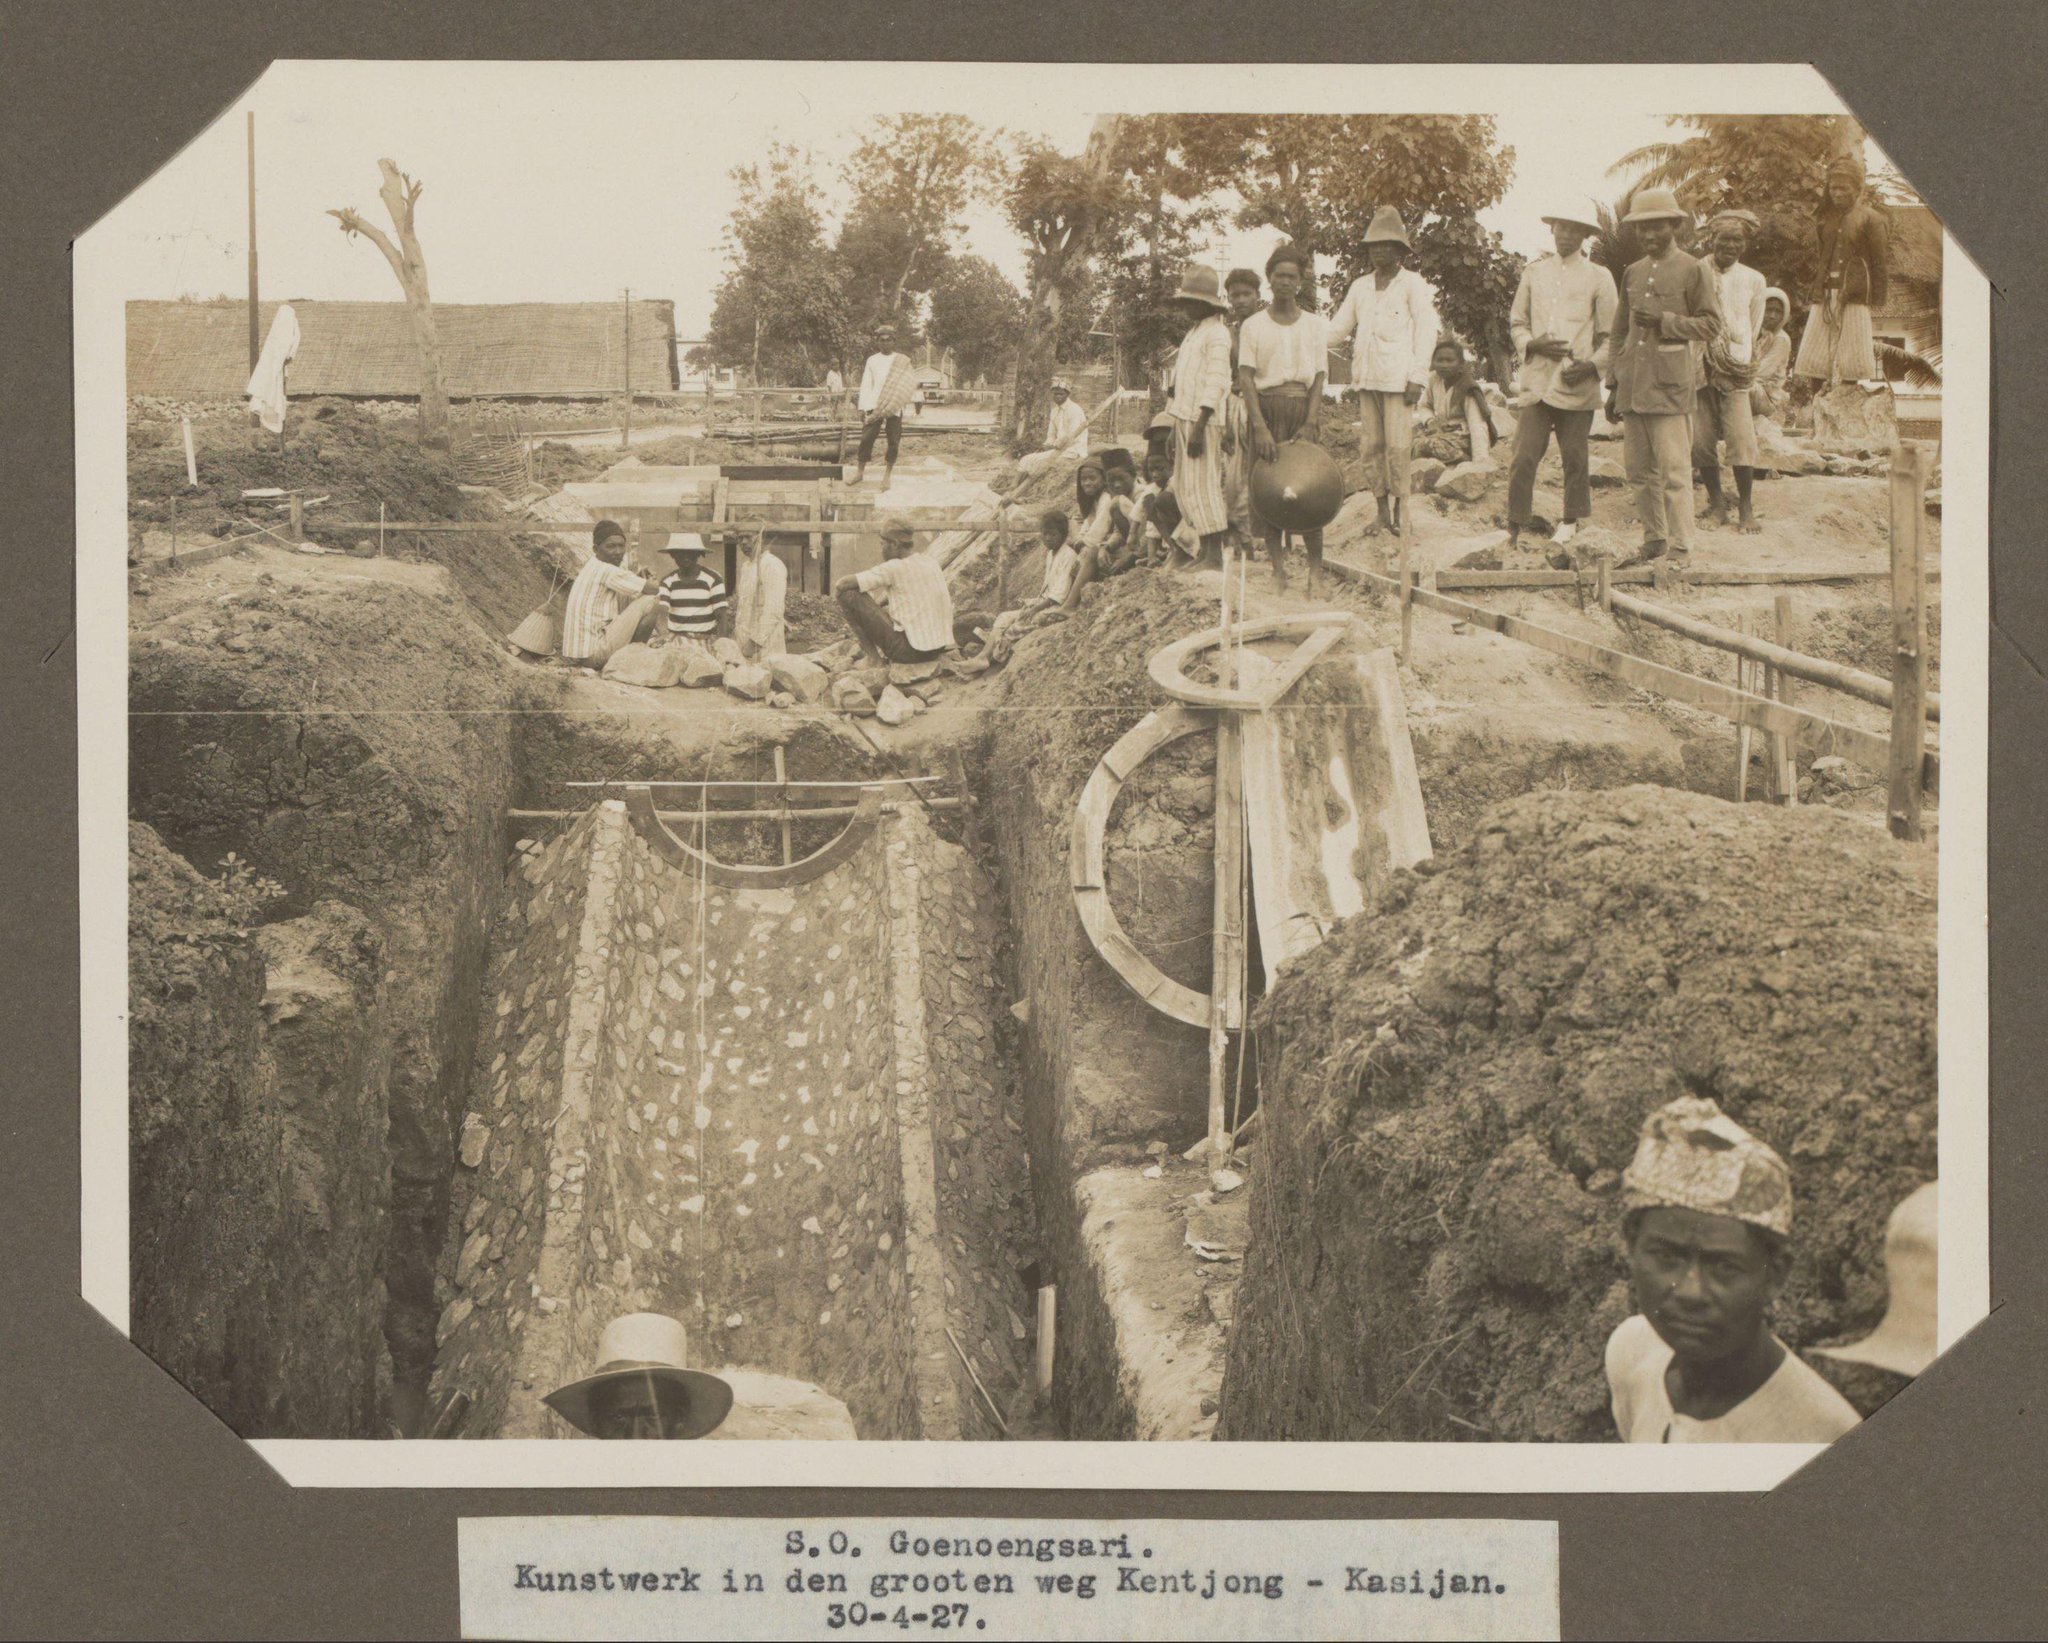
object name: photograph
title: S.O. Goenoengsari. Kunstwerk in den grooten weg Kentjong - Kasijan. 30-4-27.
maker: Anonymous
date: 1904-1927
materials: photographic support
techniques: gelatin silver print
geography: east java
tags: colonial system, trade-company, (non-fruit) products of plants or trees: sugarcane, road, path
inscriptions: inscription: ‘S.O. Goenoengsari. Kunstwerk in den grooten weg Kentjong - Kasijan. 30-4-27.’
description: Metselwerk voor de aan- en afvoerkanalen van de fabriek onder een weg, april 1927. Met poserende Javaanse arbeiders. Onderdeel van het fotoalbum met foto's van de opbouw van de suikerfabriek te Goenoengsari op Oost-Java door de Handels Vereniging Amsterdam 1926-1927.